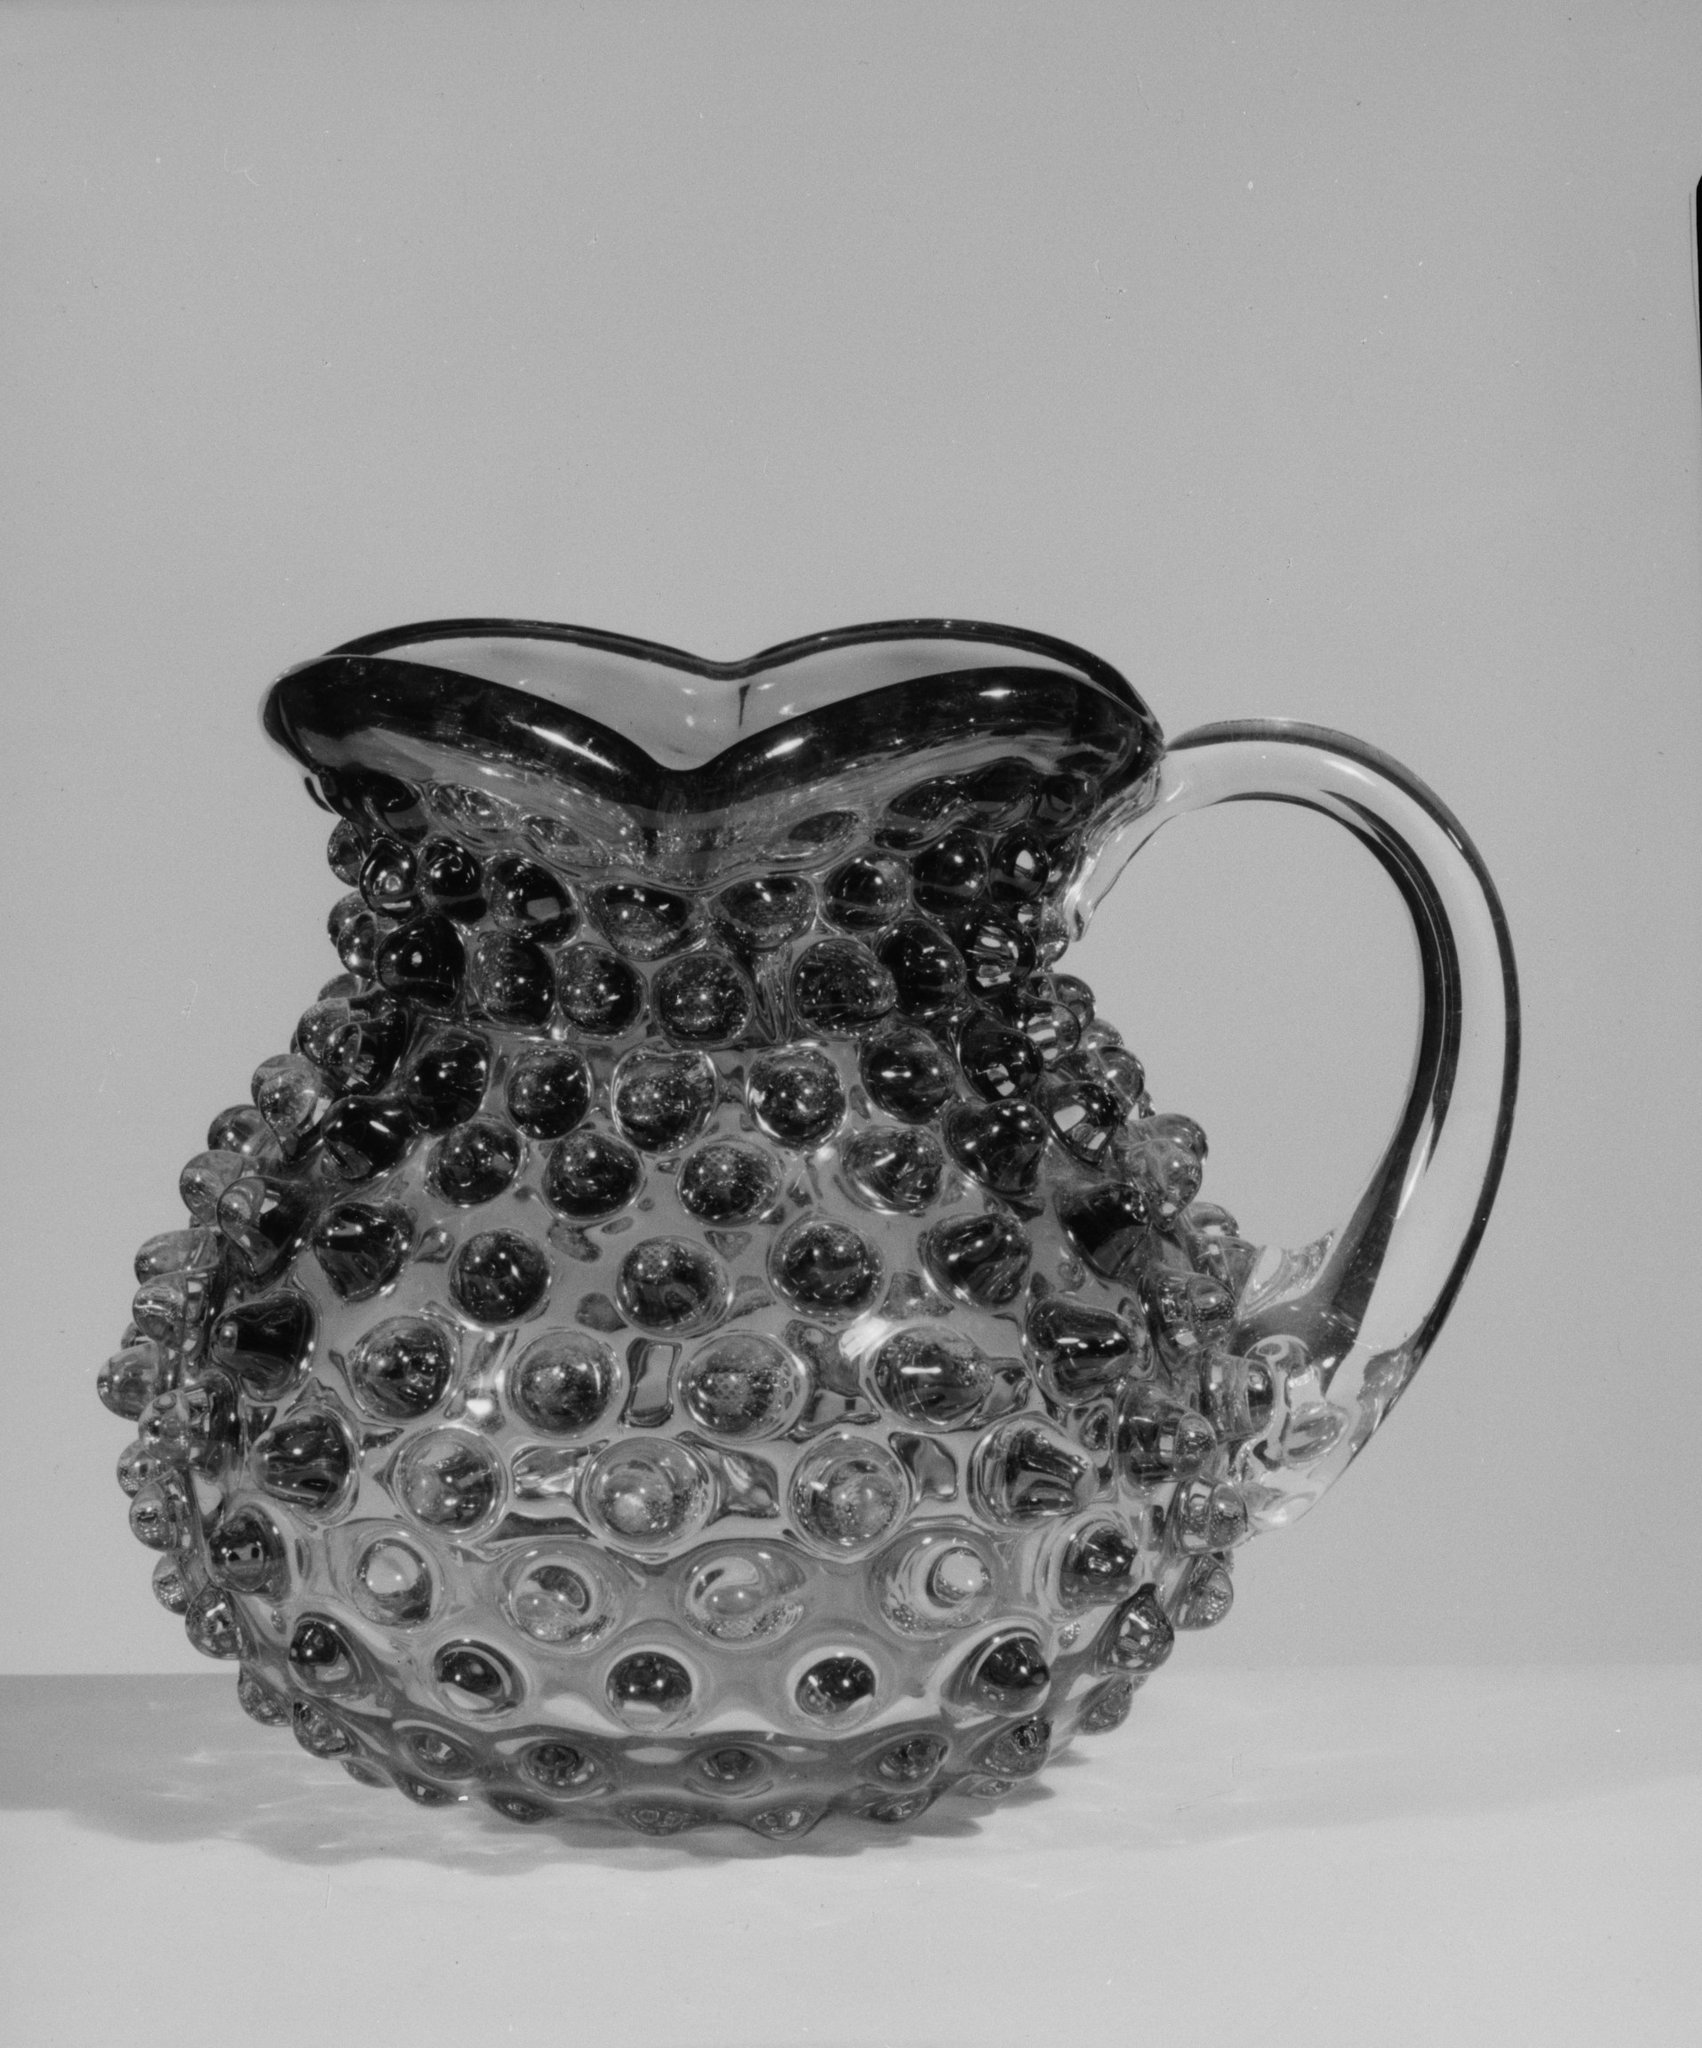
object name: cream pot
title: Hobnail Creamer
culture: american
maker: hobbs, brockunier and company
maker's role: maker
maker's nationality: american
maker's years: 1863-1891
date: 1886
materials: glass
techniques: pressed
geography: united states